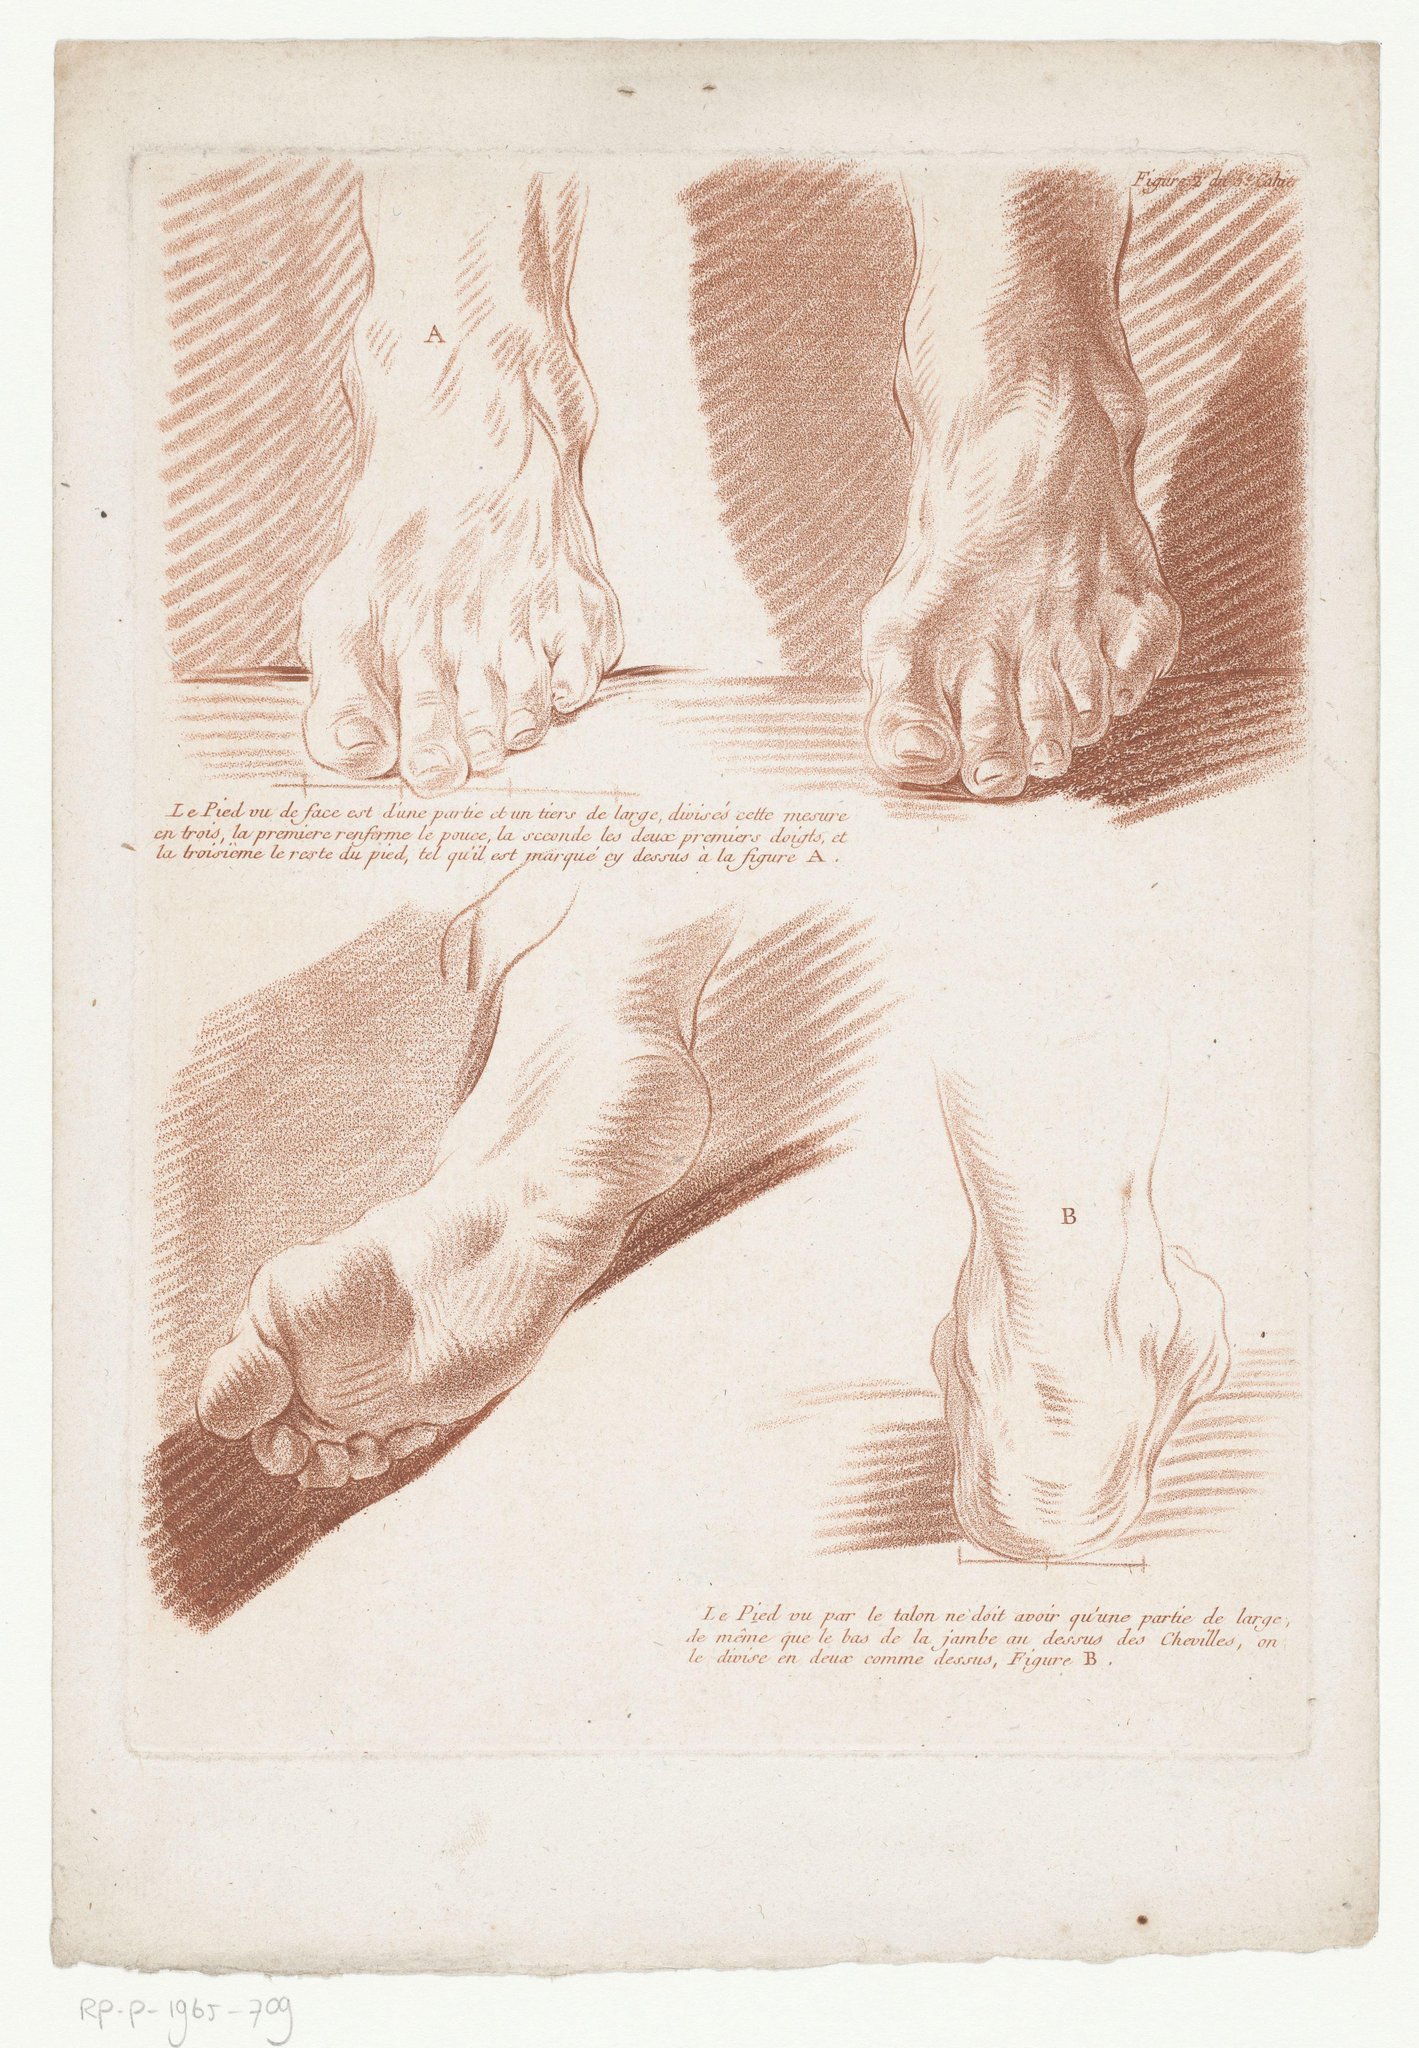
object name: print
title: Vier voeten in verschillende posities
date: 1773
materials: paper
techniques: printmaking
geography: paris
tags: foot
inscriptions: collector's mark: Lugt 2228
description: Deze prent maakt deel uit van een album dat uit minstens elf delen bestaat. Dit is de tweede figuur van het vijfde album. Waarschijnlijk dienden deze albums als voorbeeld voor tekenaars, schilders en graveurs.